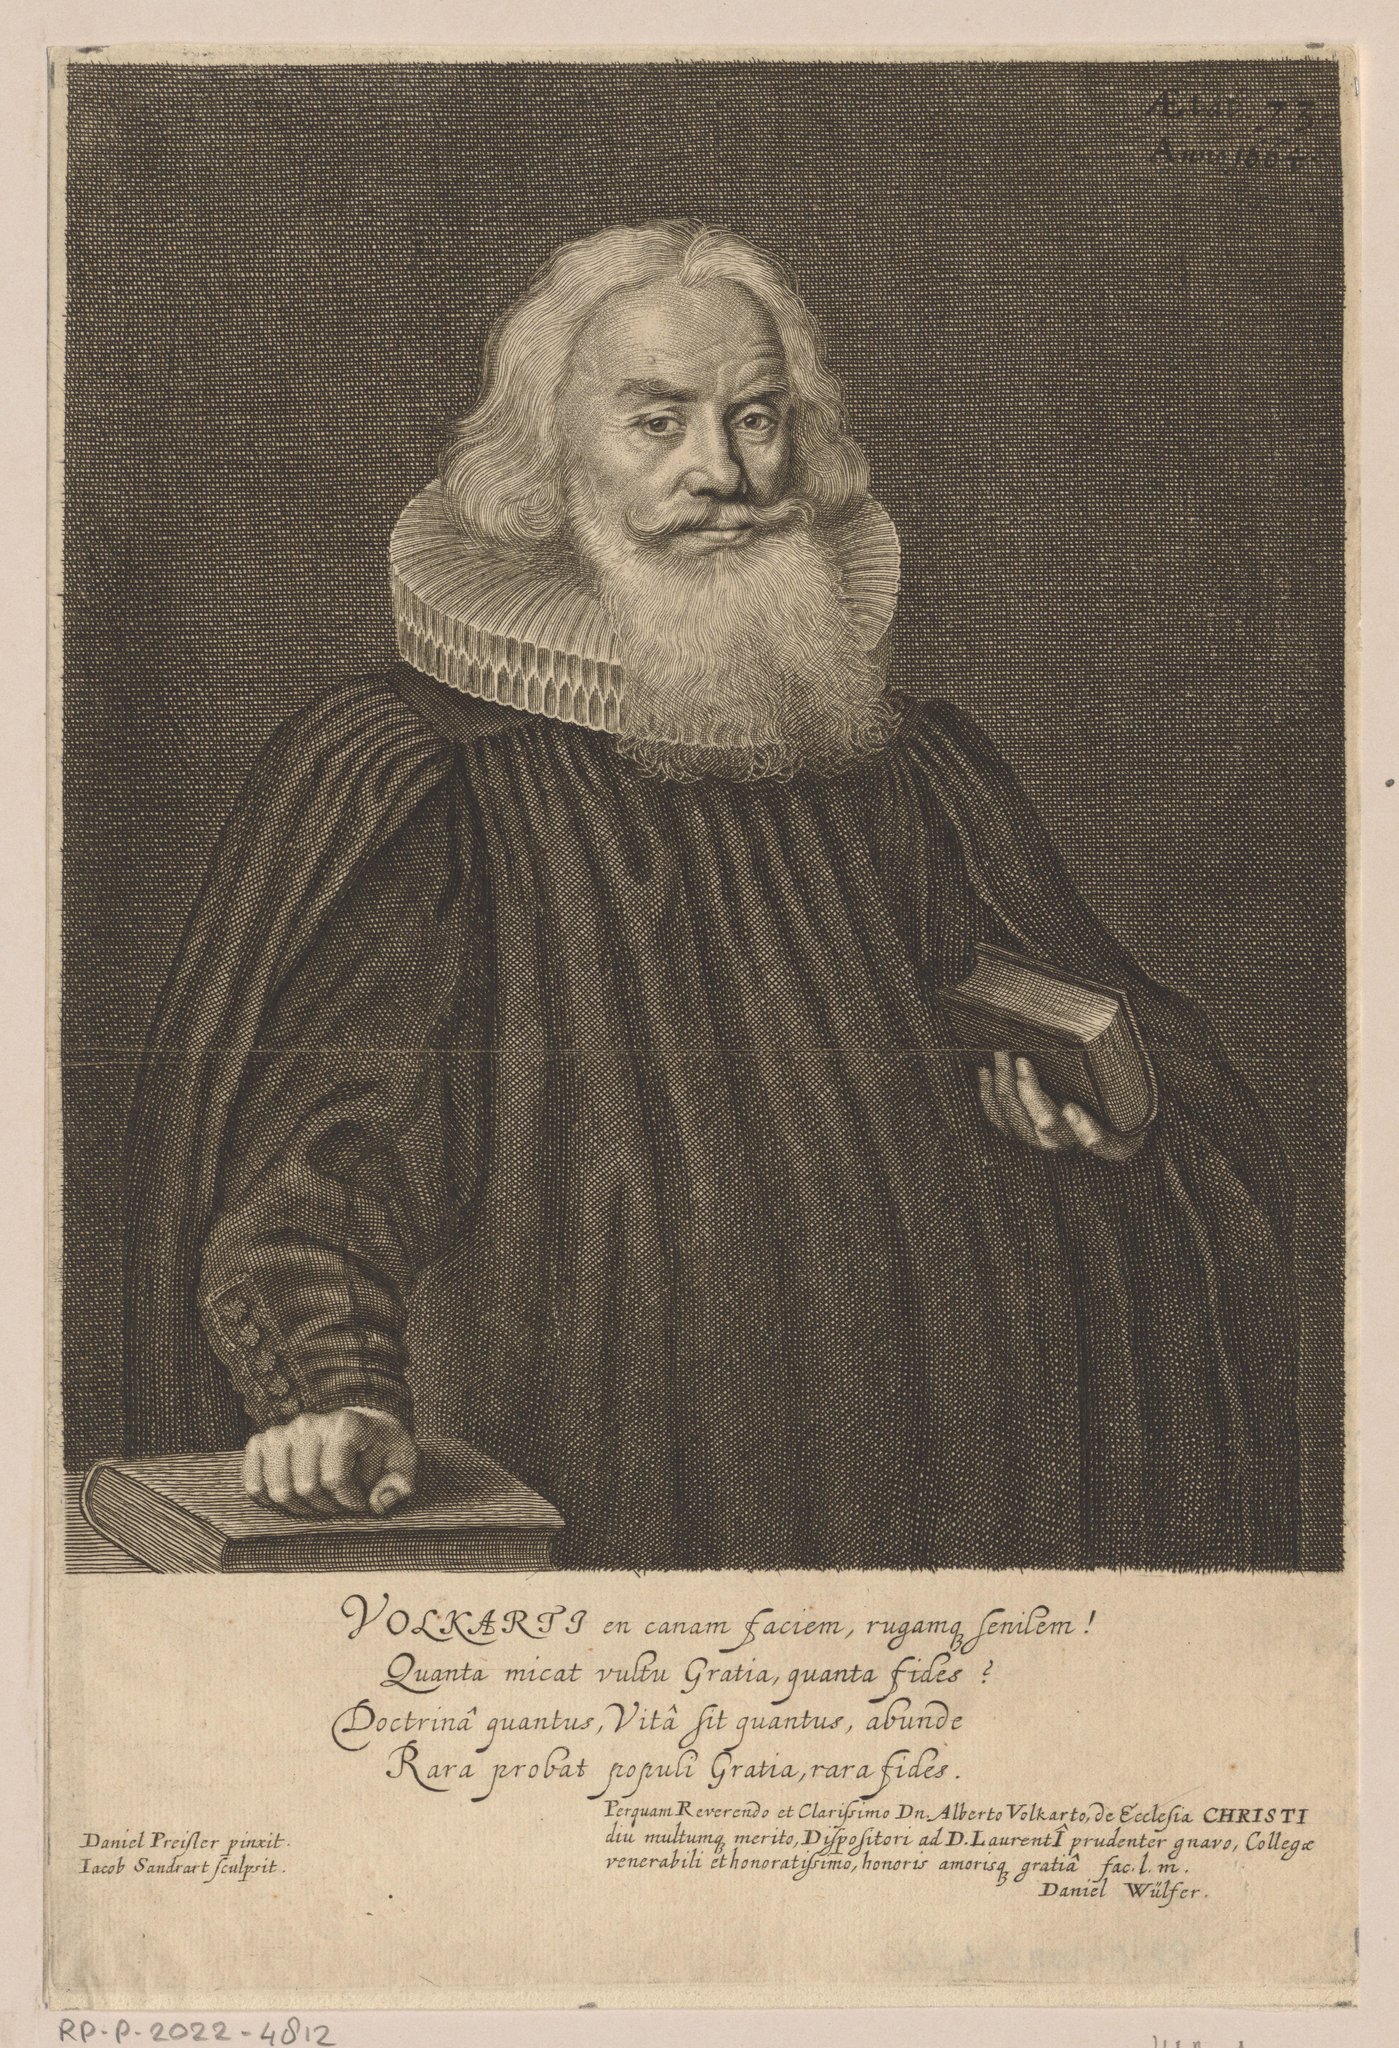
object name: print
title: Portret van Albrecht Volckhard op 73-jarige leeftijd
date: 1666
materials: paper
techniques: engraving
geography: germany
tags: theologian, historical persons